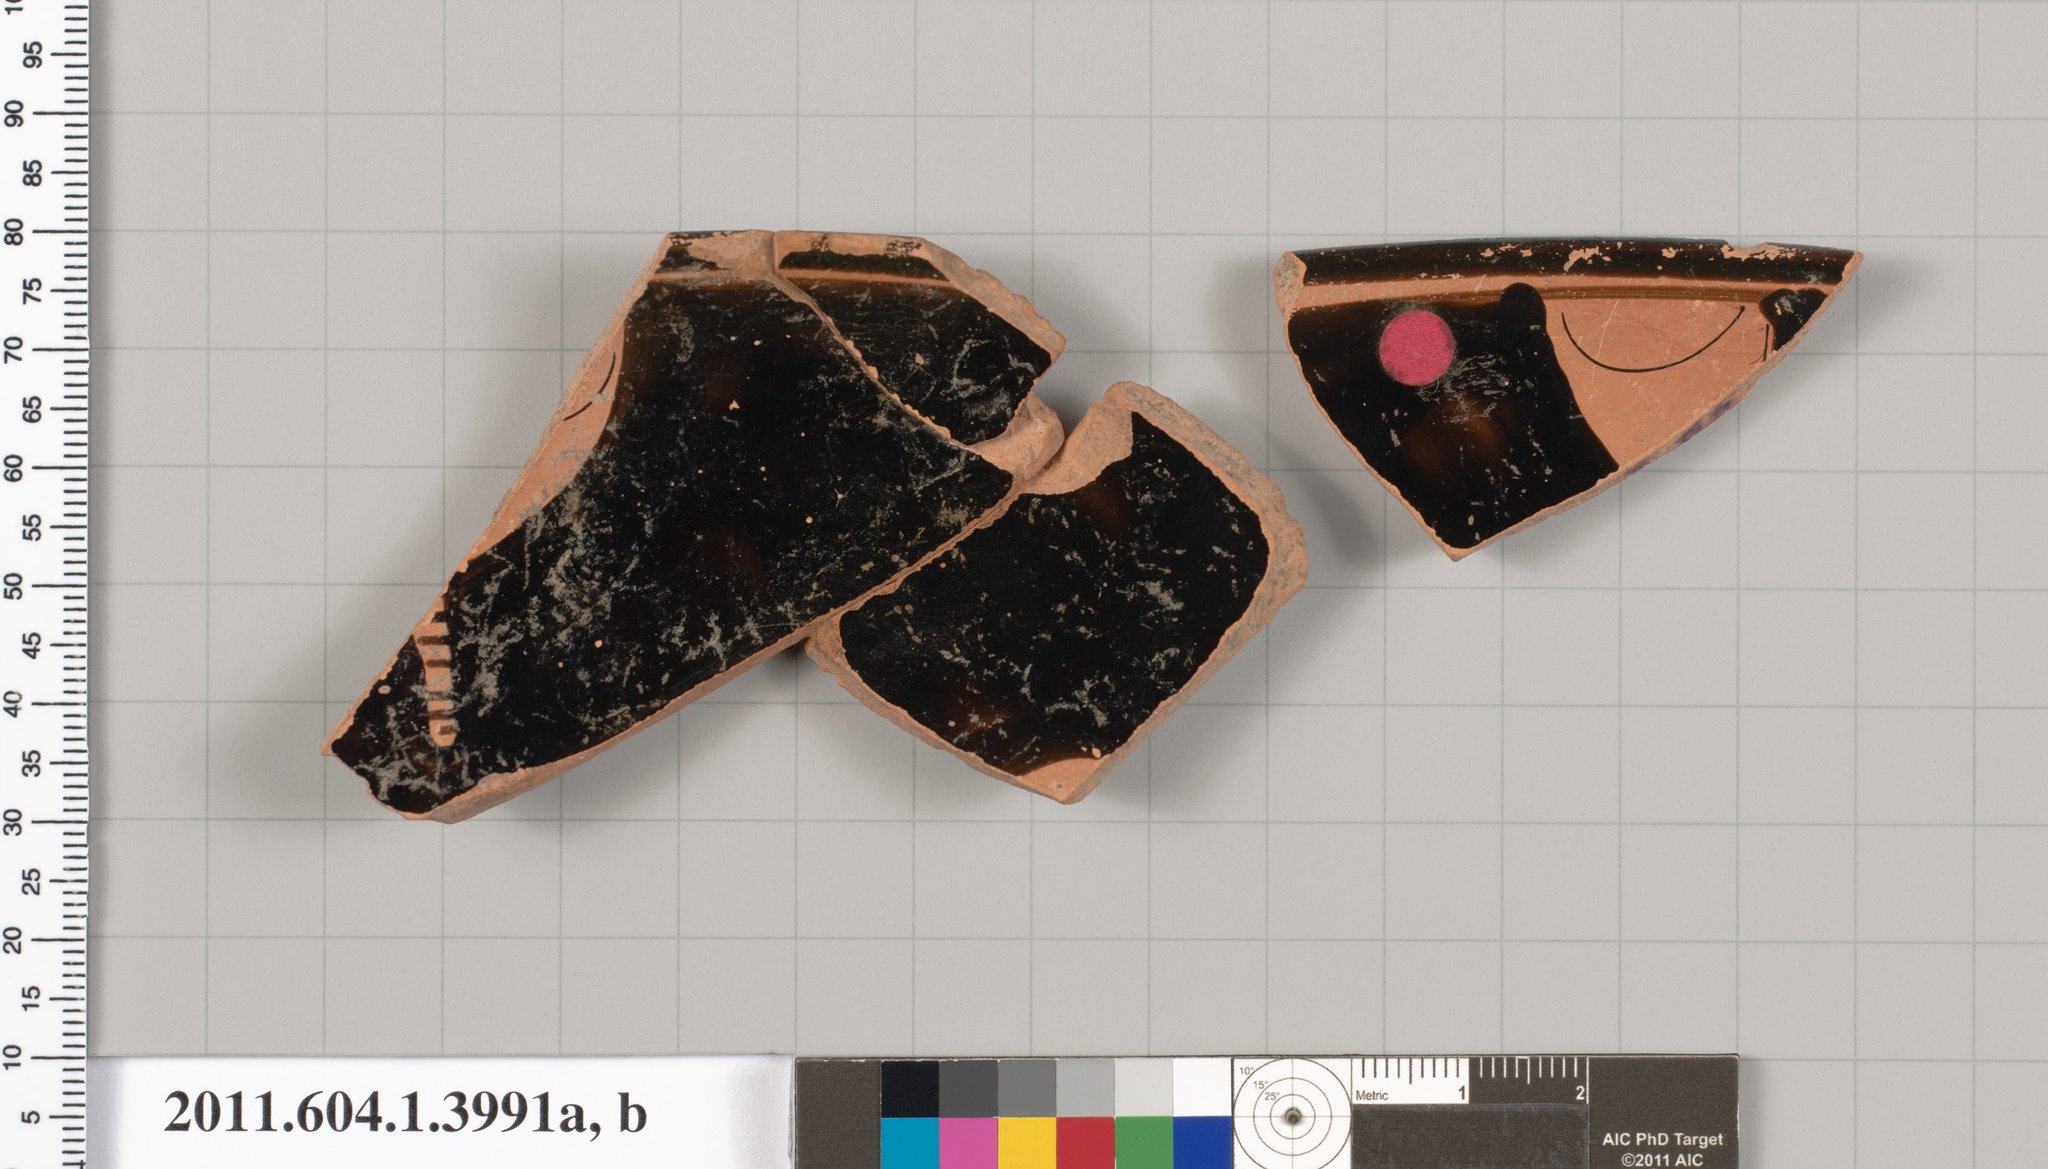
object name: kylix fragment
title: Terracotta fragments of a kylix (drinking cup)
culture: greek, attic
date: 475-451 BCE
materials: terracotta